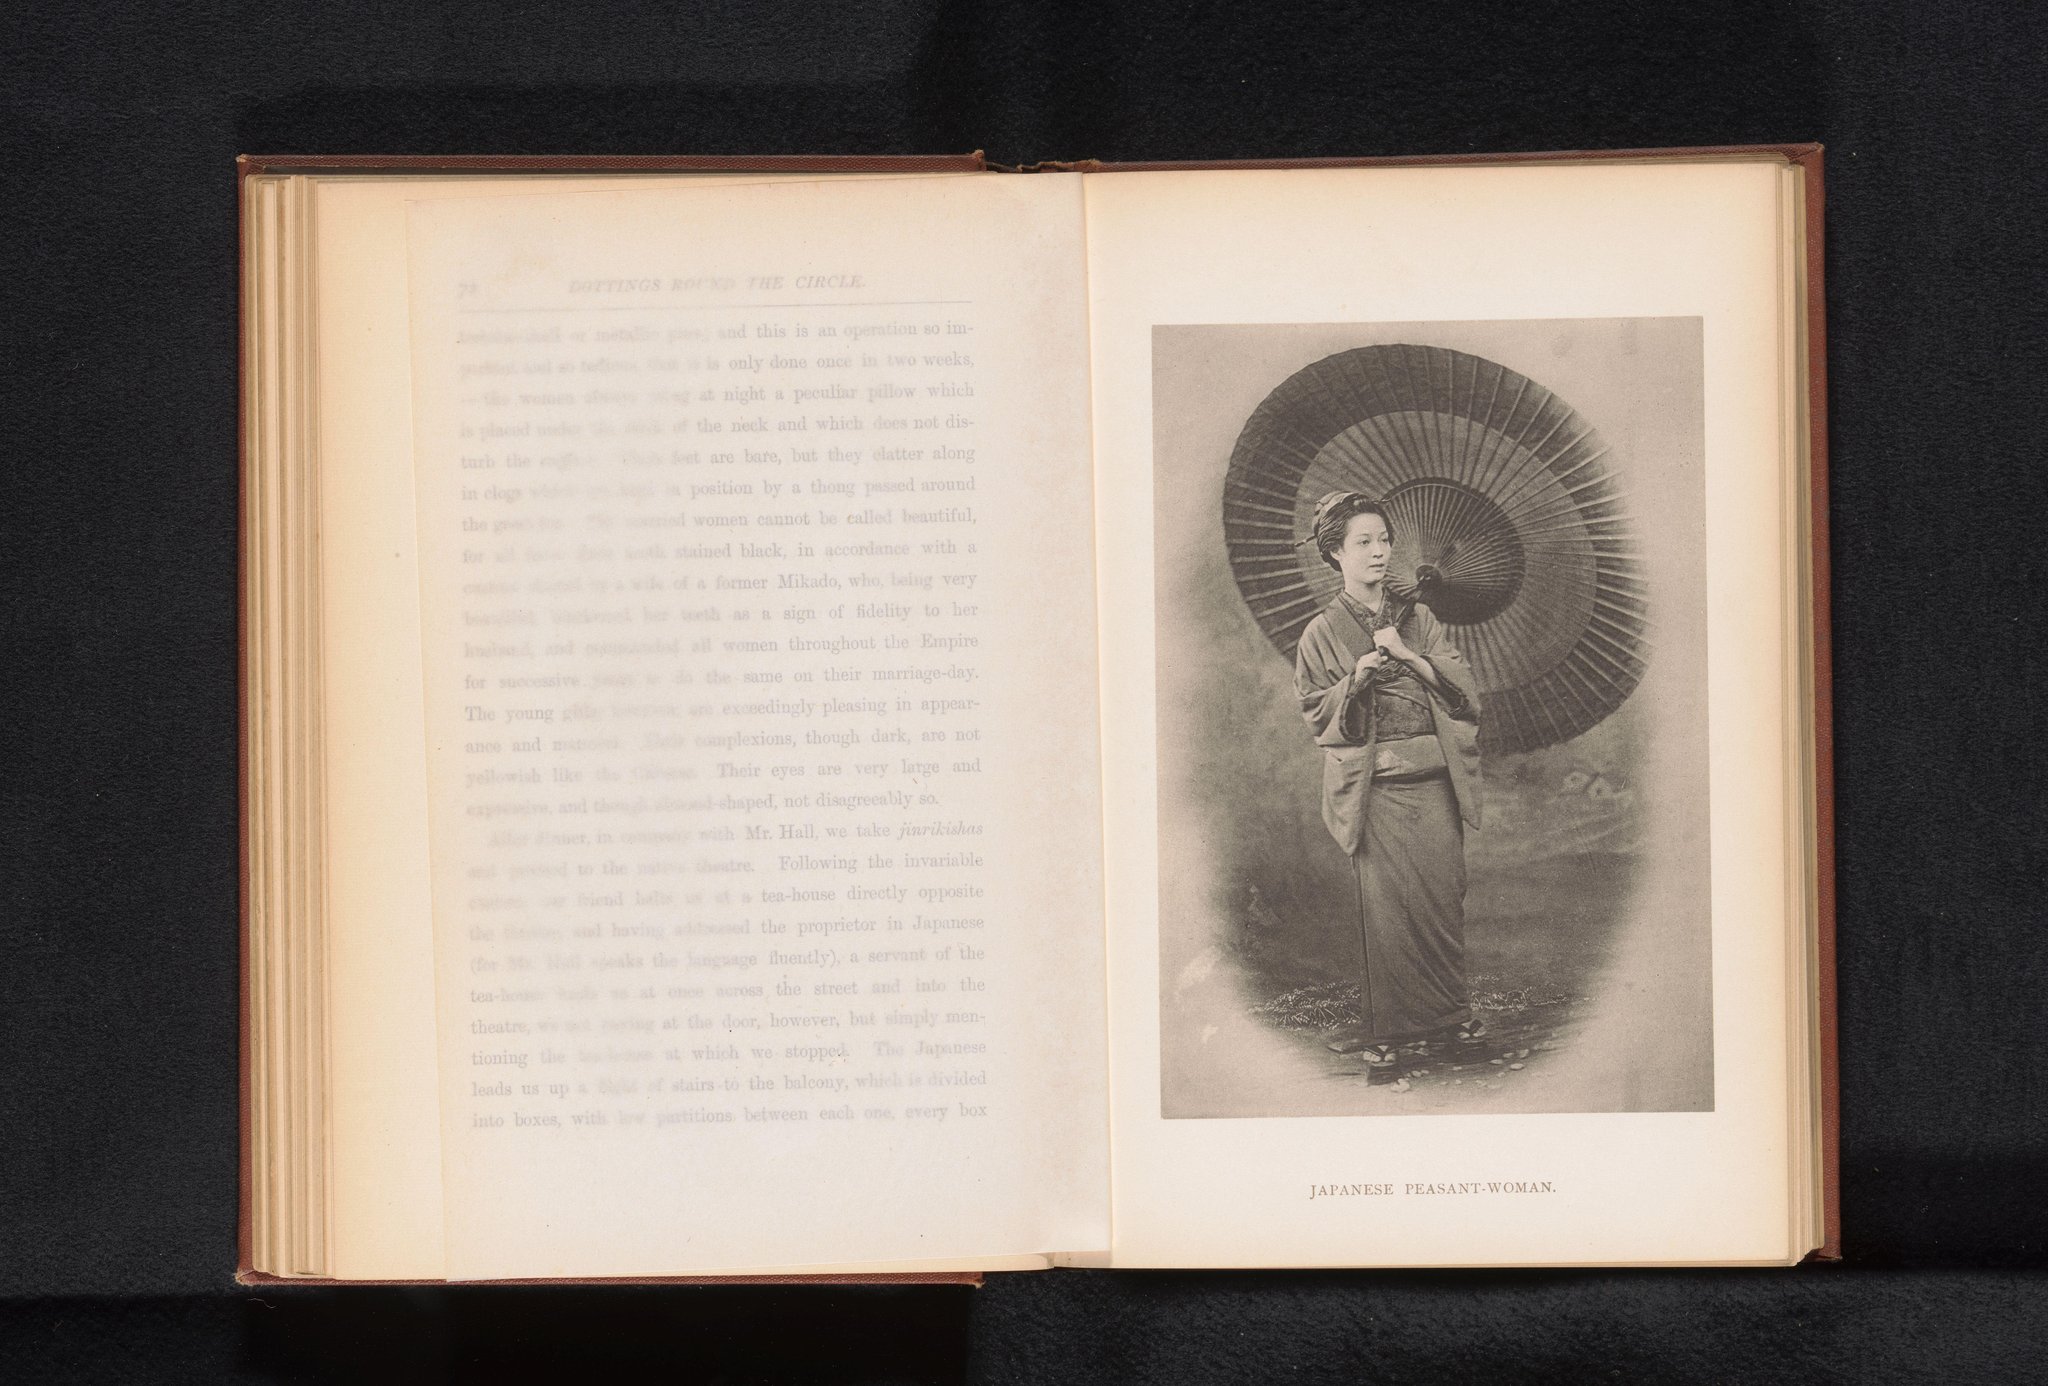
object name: page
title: Portret van een onbekende vrouw in Japanse kleding met een parasol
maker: Anonymous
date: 1866-1876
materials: paper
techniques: photoaquatint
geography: japan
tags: adult woman, courtesan, hetaera, folk costume, regional costume